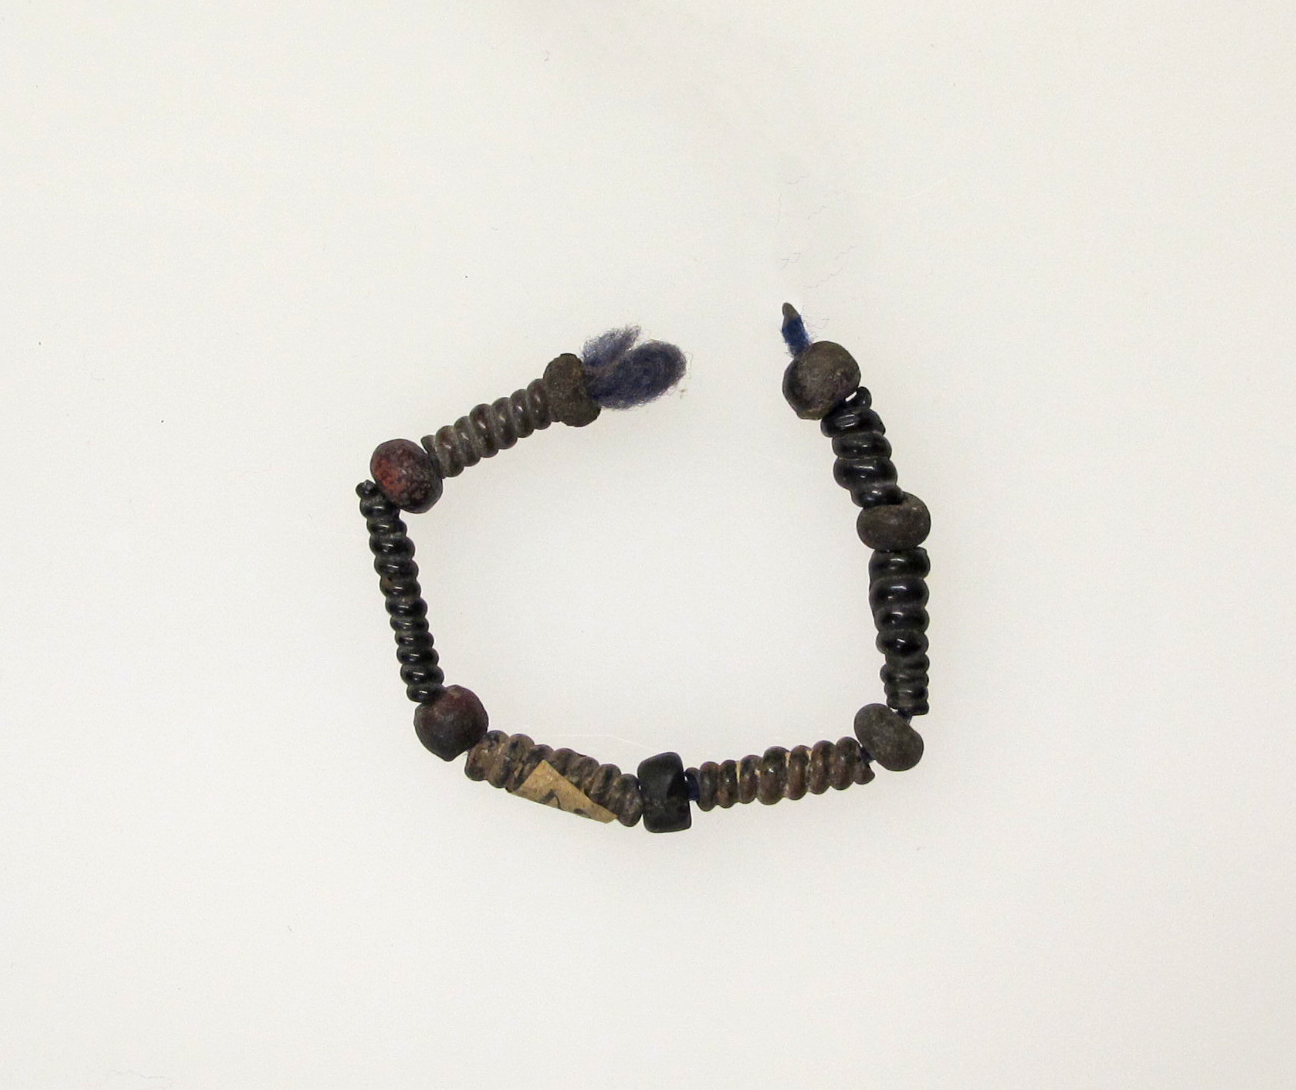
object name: bead, 13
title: Beads, 13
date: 7000 BCE-330 CE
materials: glass